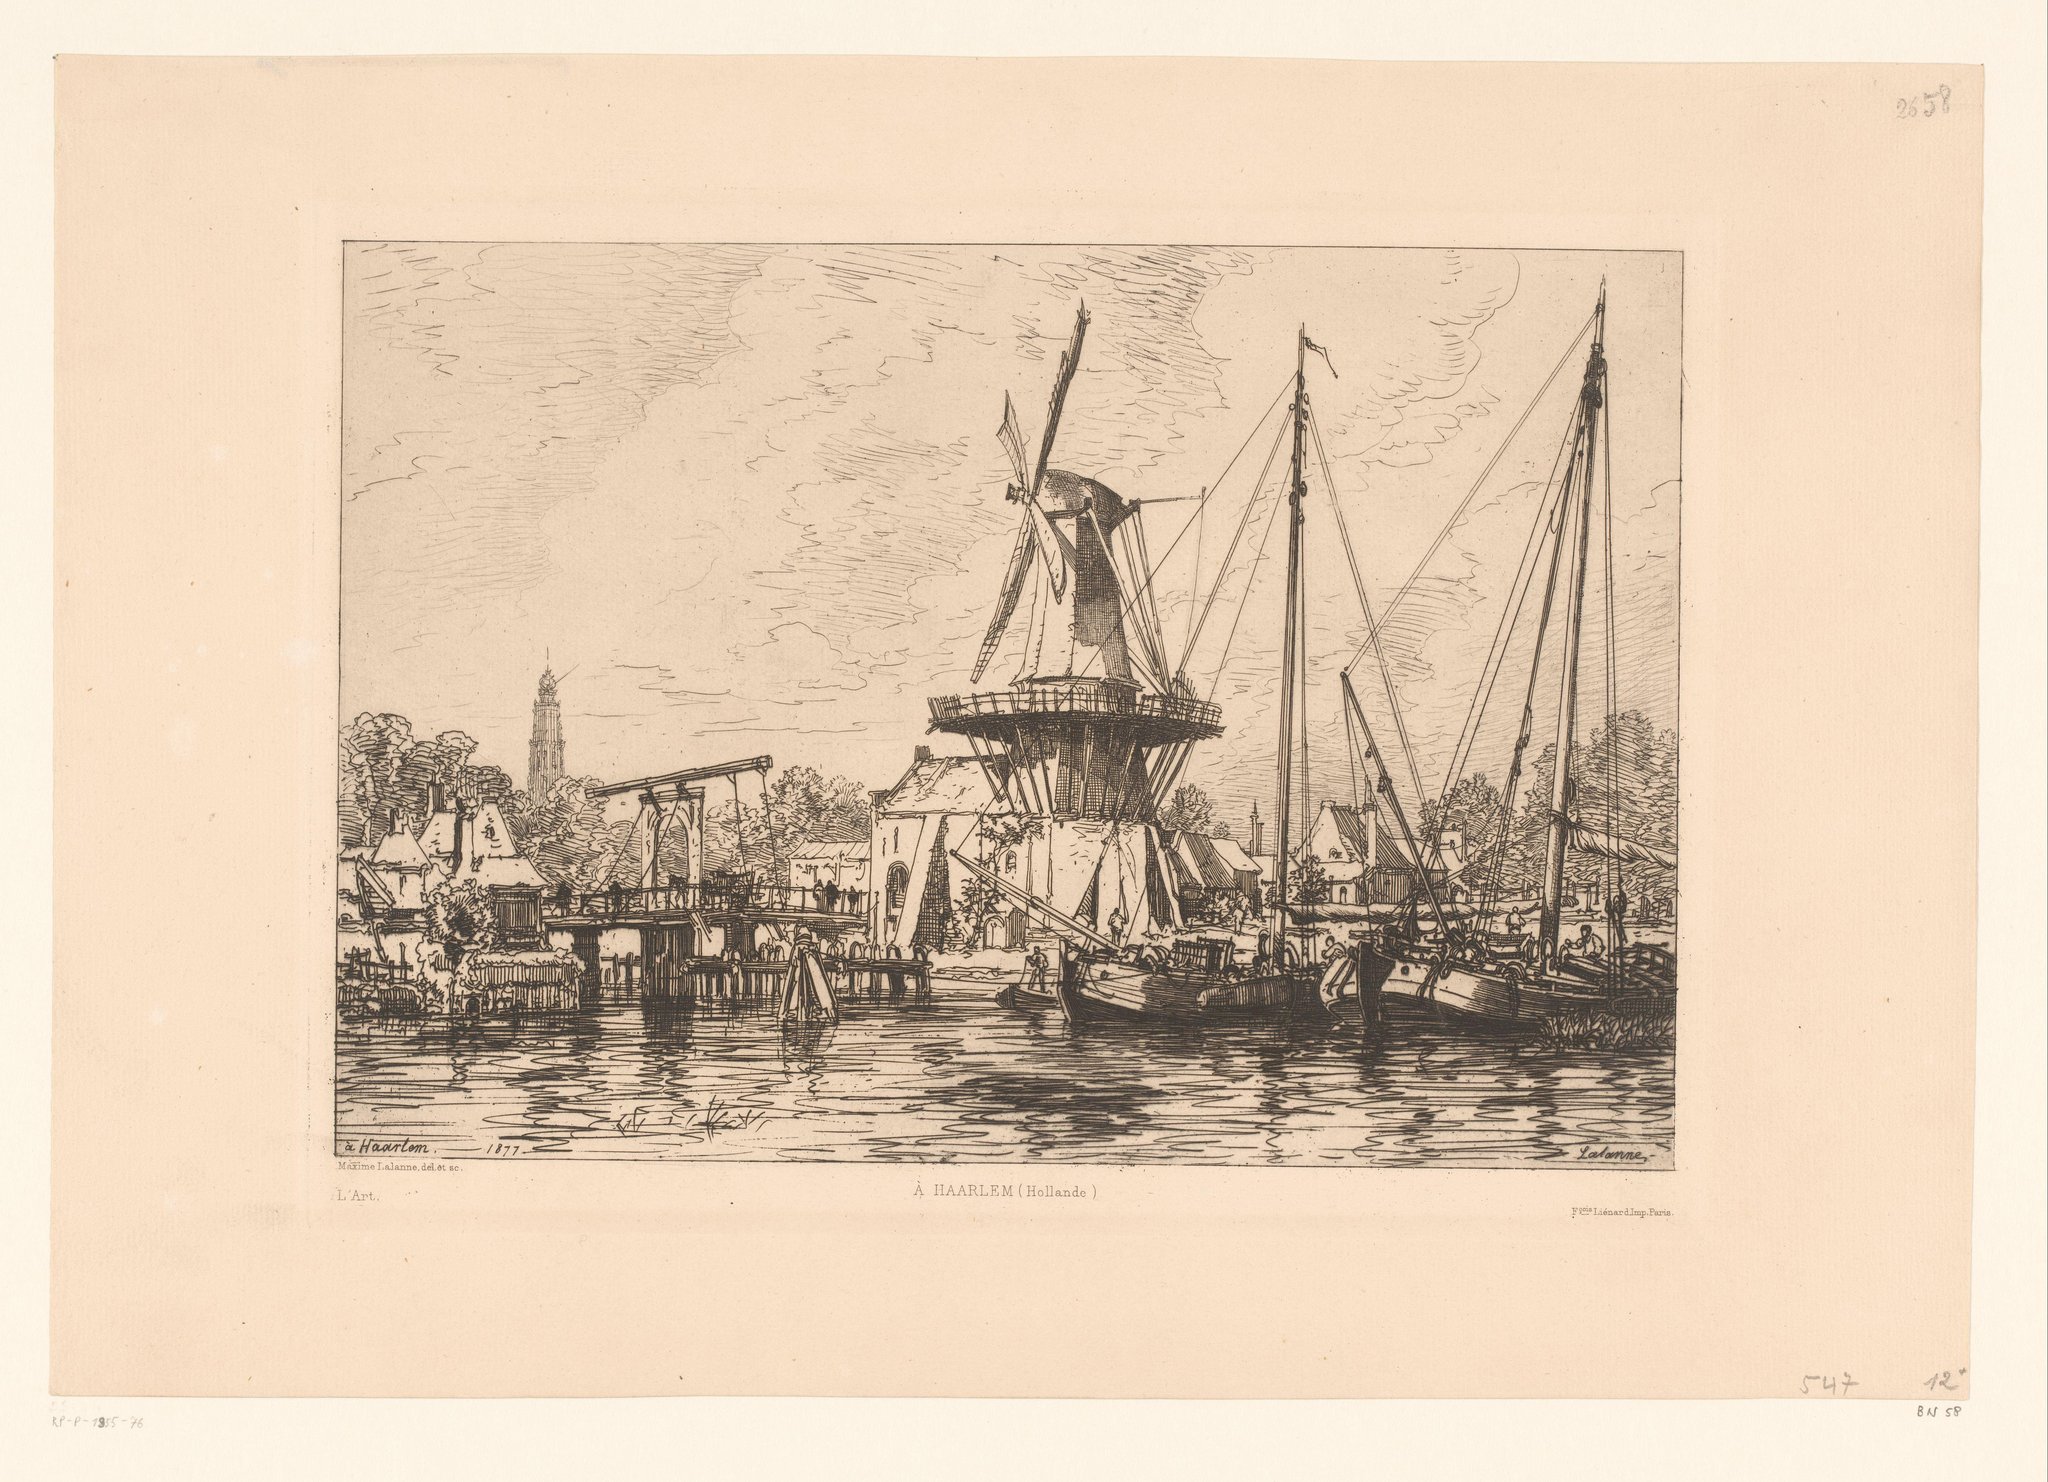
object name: print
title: À Haarlem (Hollande)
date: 1877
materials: paper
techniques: drypoint, engraving, etching, intaglio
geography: paris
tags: city-view, and landscape with man-made constructions, water course, haarlem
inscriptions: collector's mark: Lugt 2228